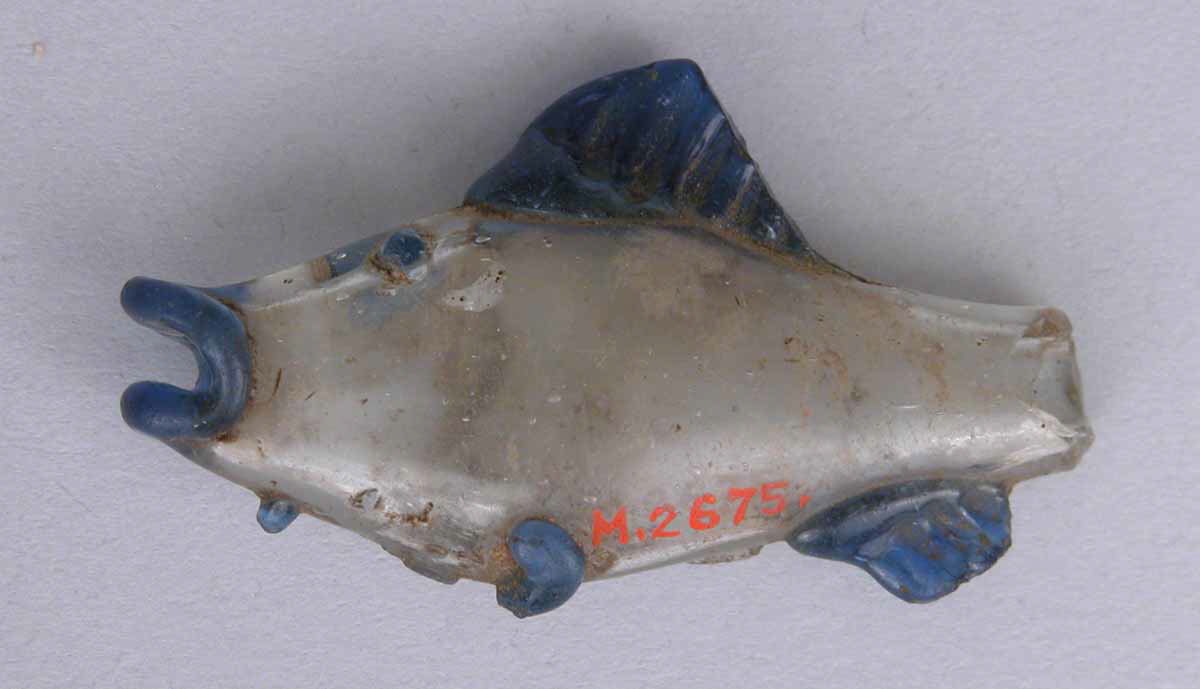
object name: figurine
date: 201-1200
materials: glass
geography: egypt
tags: fish